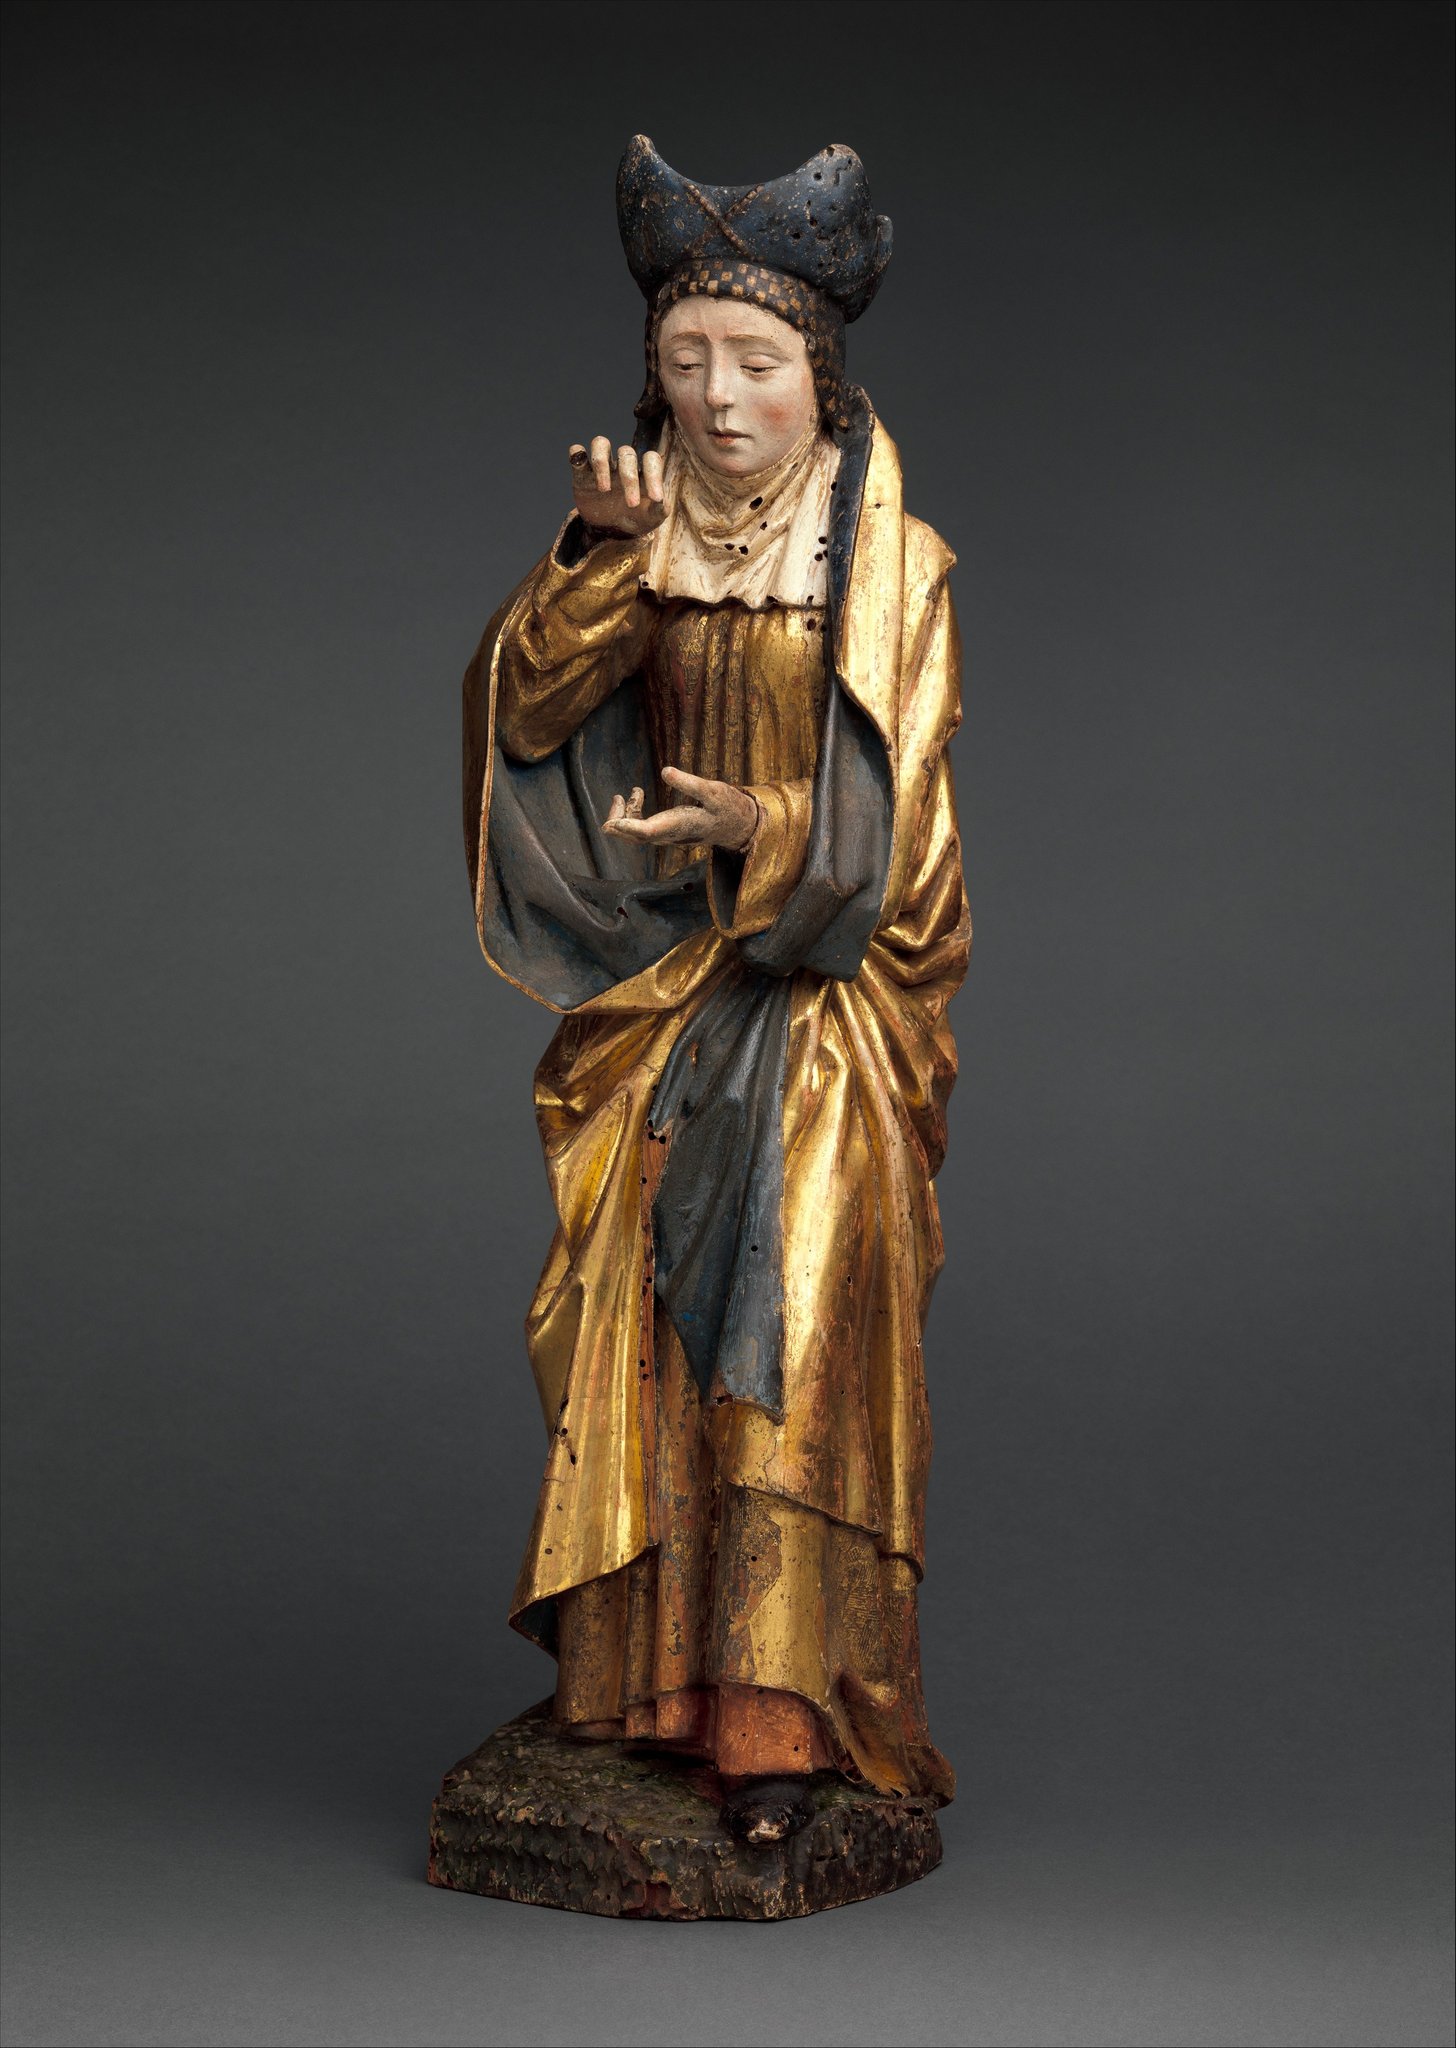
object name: statuette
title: Holy Woman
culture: south netherlandish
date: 1480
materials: wood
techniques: gilding, polychromy